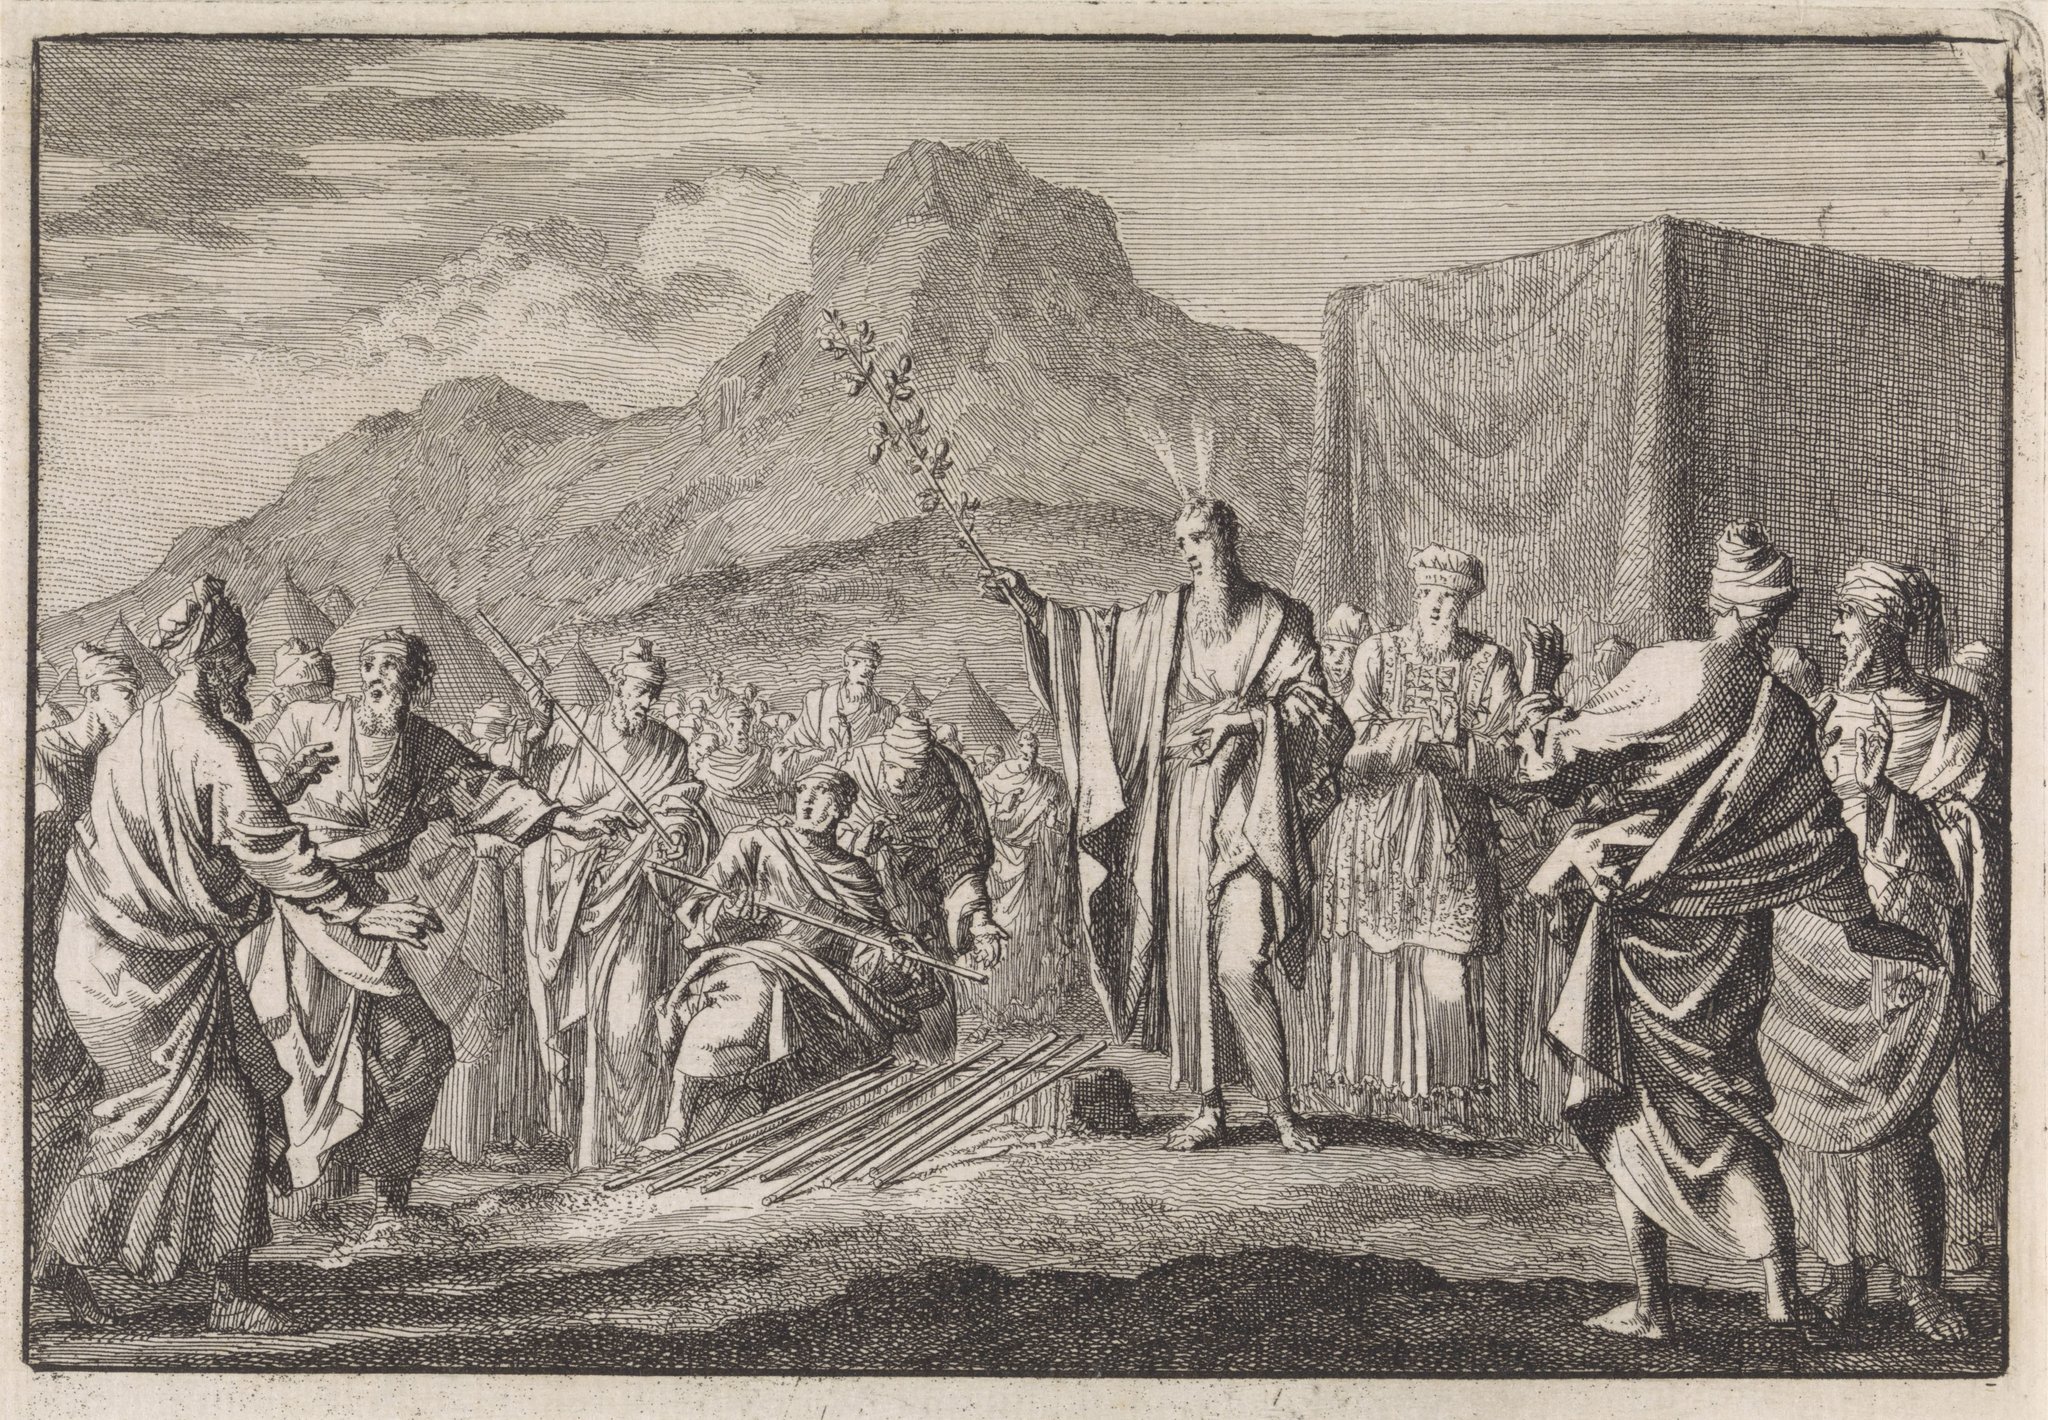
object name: print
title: Mozes toont de bloeiende staf van Aäron aan de stamhoofden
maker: jan luyken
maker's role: draughtsman, print maker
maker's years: 1649-1712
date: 1704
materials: paper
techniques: etching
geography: amsterdam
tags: moses shows the flowering rod of aaron to the community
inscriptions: collector's mark: Lugt 2228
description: Prent ook gebruikt als boekillustratie in: Josephus, Flavius. Alle de Werken, 2 delen. Amsterdam: Pieter Mortier, 1704, dl. 1, p. 82.